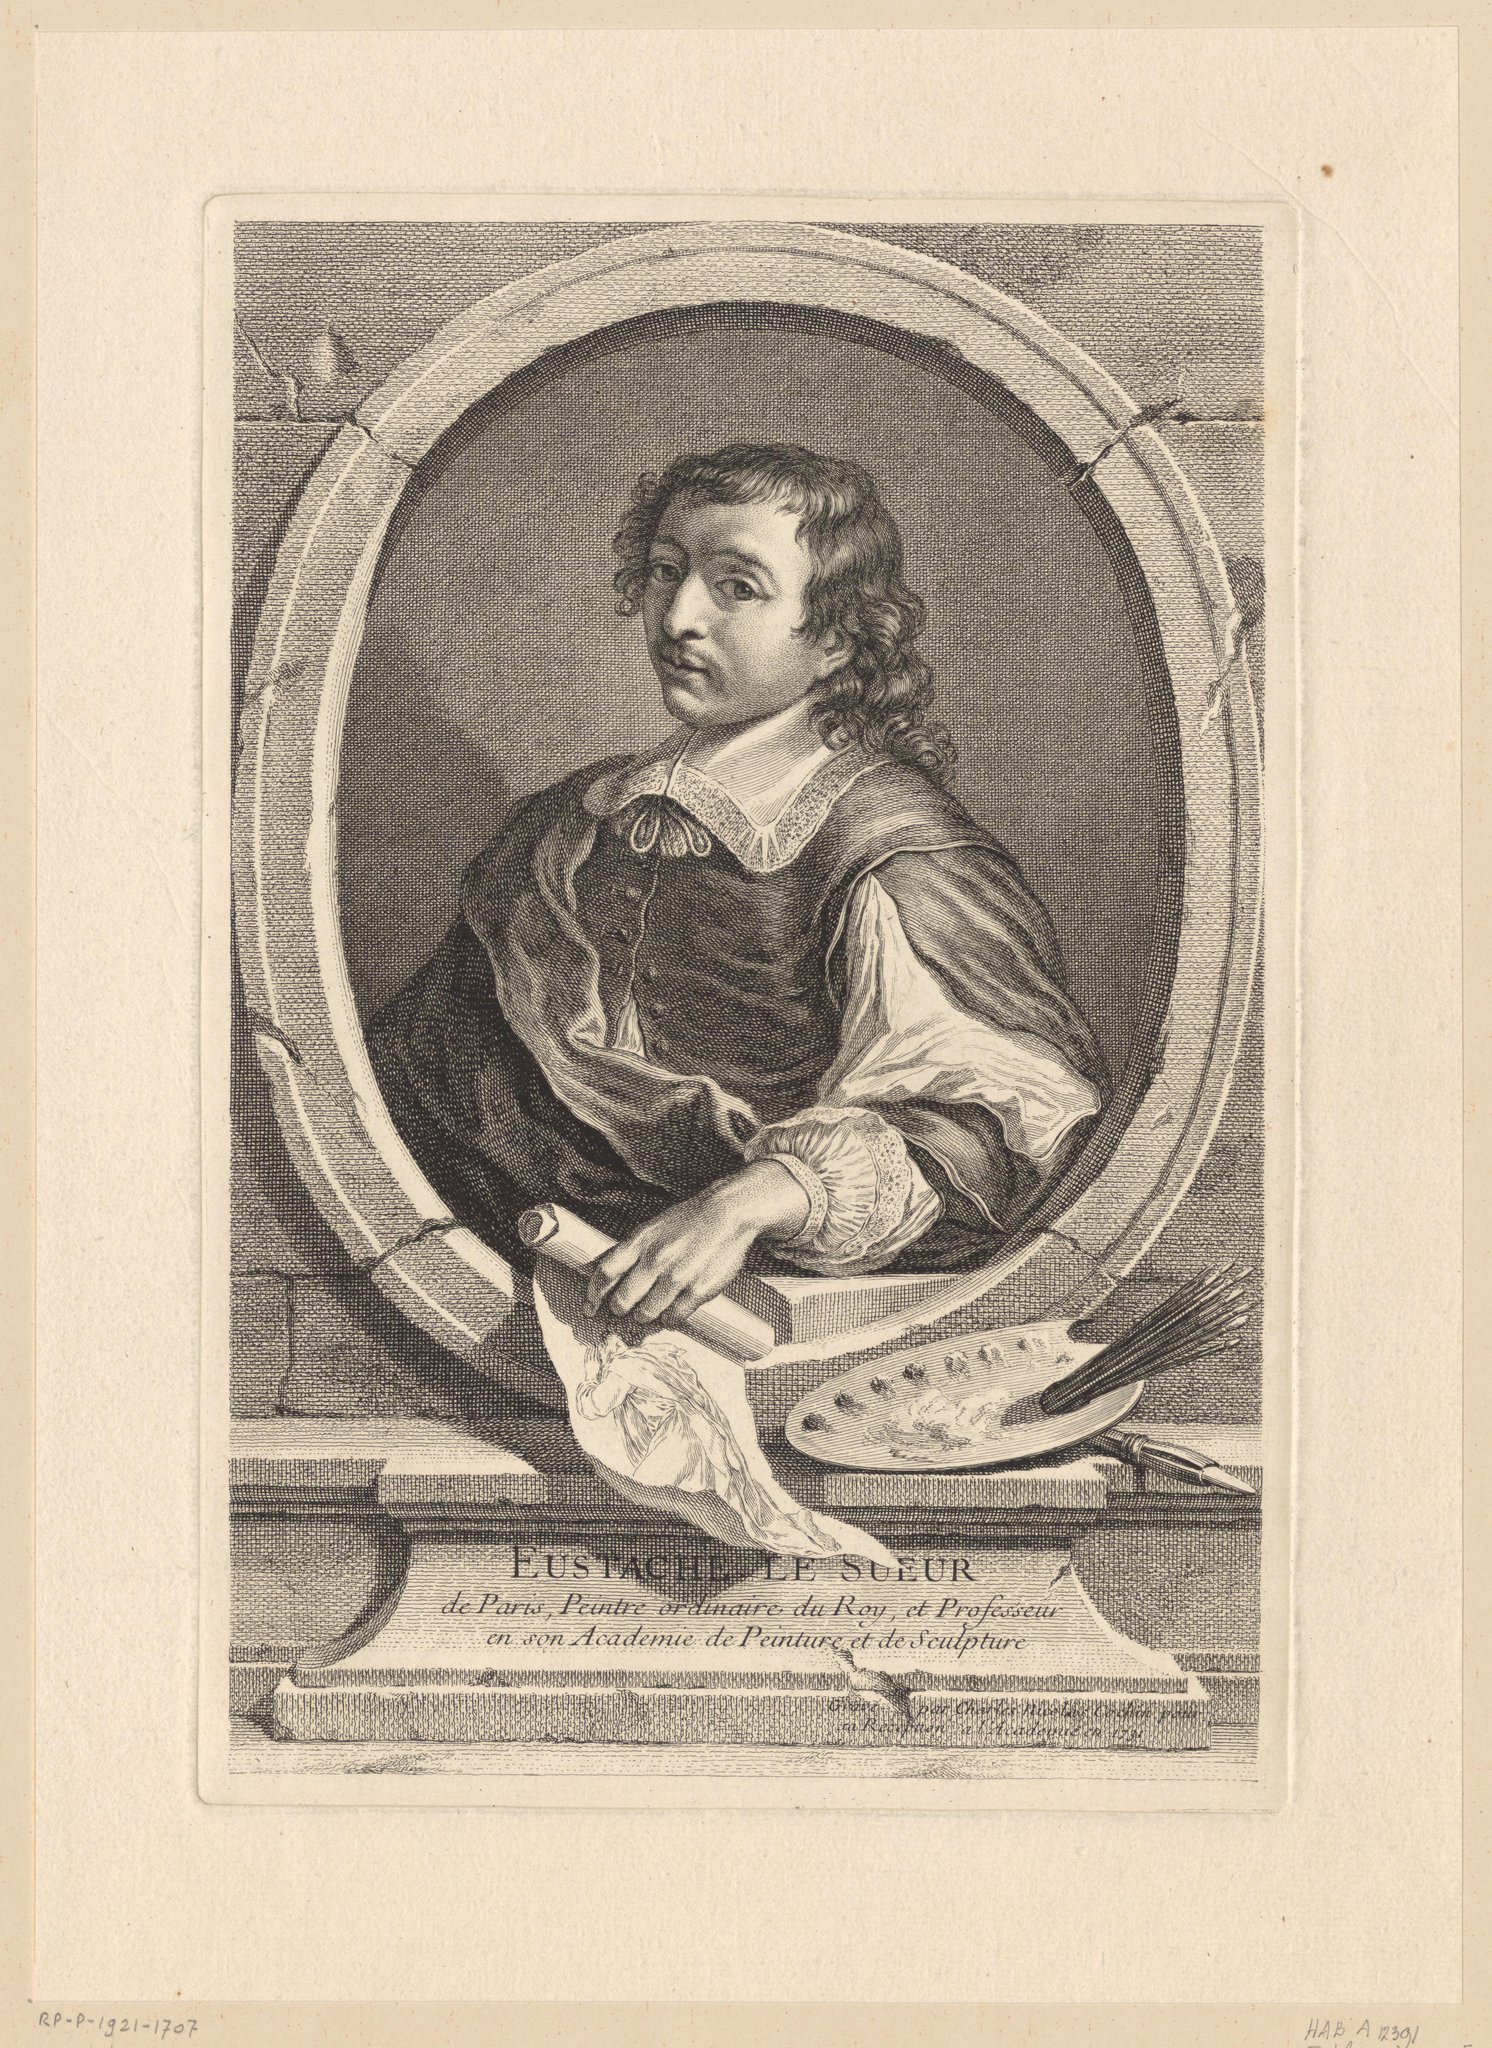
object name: print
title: Eustache le Sueur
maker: charles nicolas cochin (i)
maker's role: print maker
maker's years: 1688-1754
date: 1731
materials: paper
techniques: engraving, etching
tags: painter, draughtsman, eustache lesueur, historical persons, portrait, self-portrait of painter, tools, implements of painter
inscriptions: collector's mark: Lugt 2233